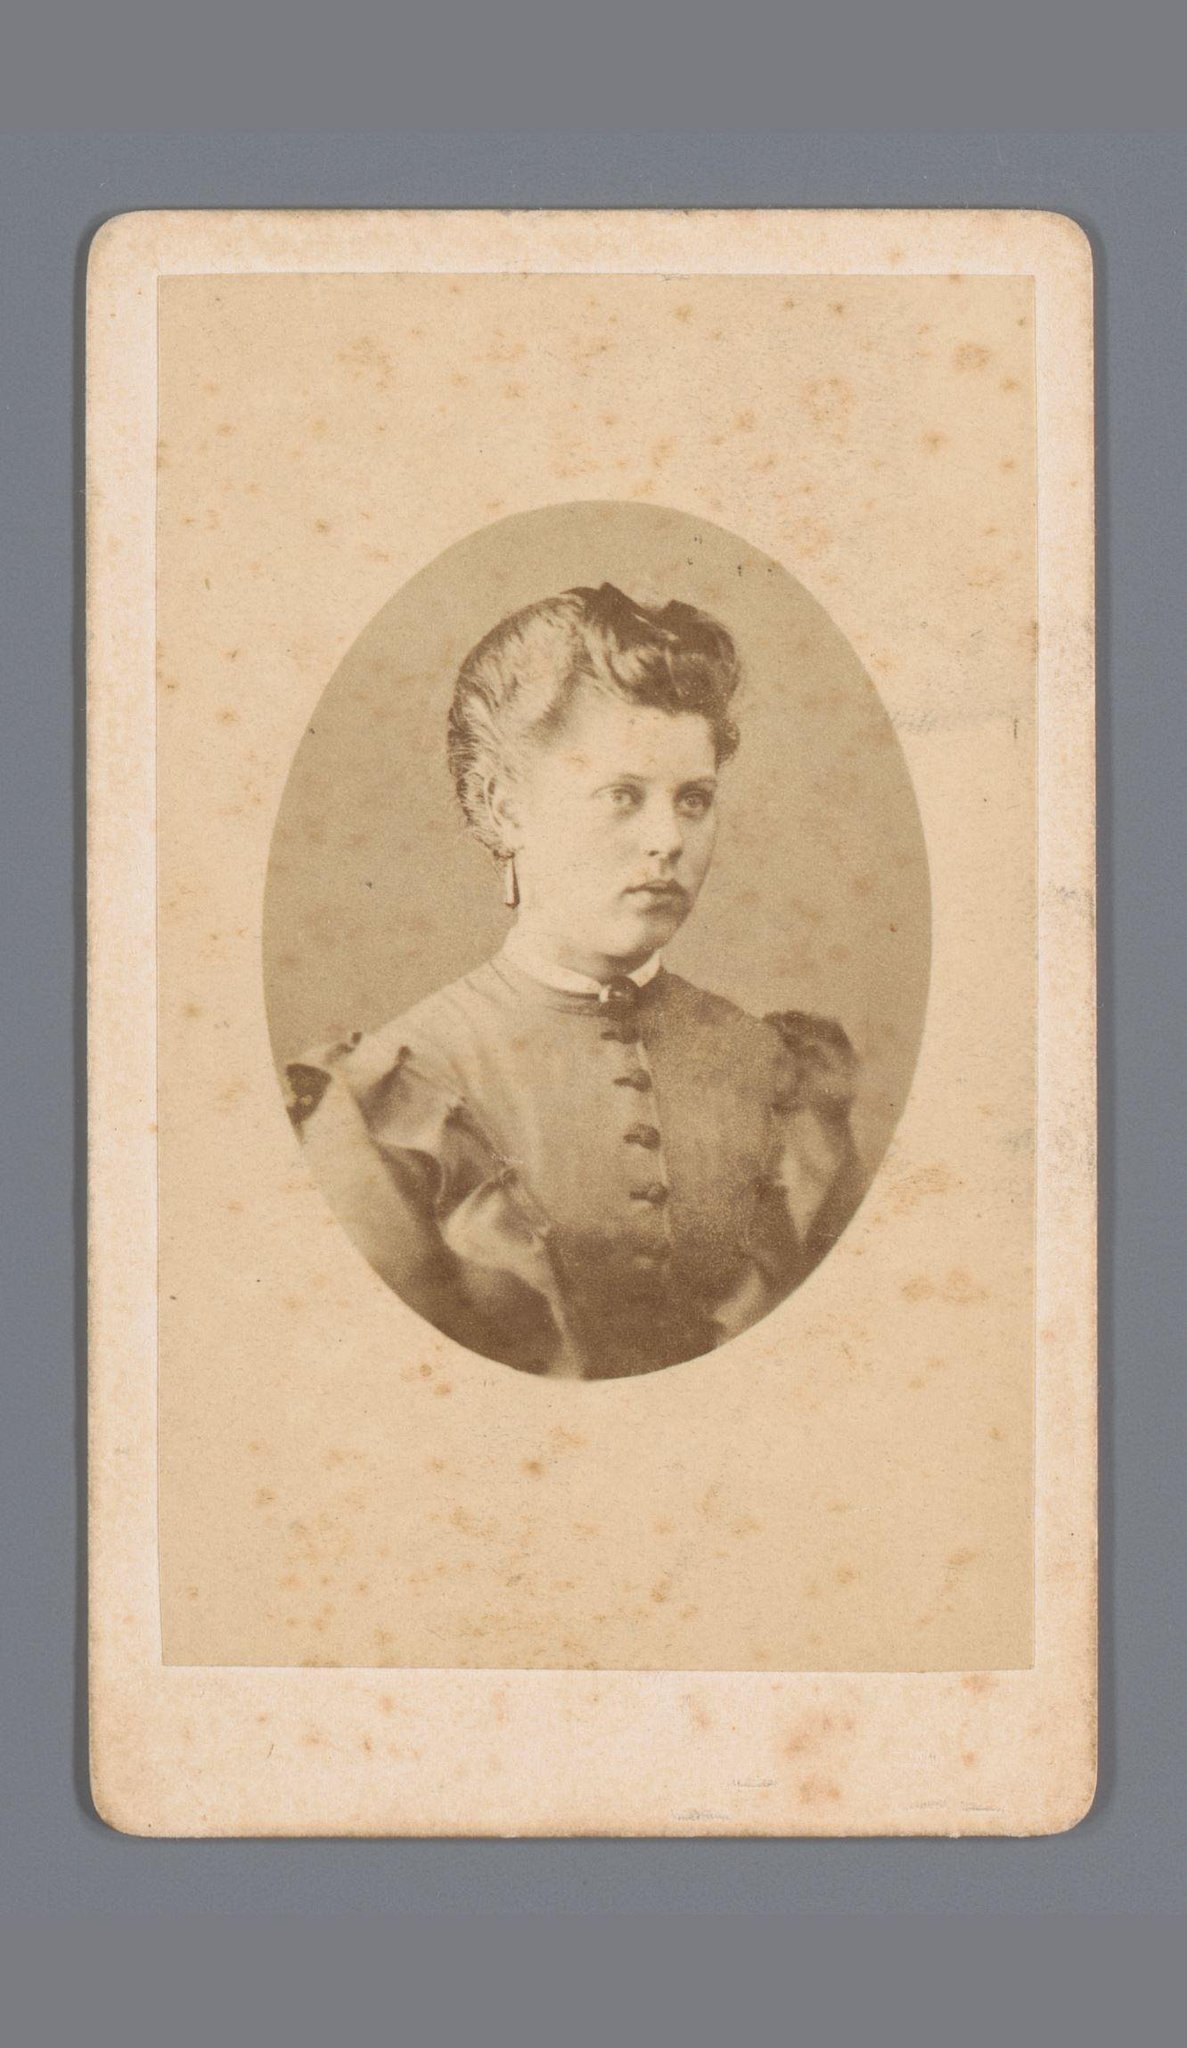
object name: carte de visite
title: Portret van Christine Keyser Temmink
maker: bernardus bruining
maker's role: fotograaf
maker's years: 1834-1900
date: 1860-1877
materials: cardboard, photographic support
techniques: albumen print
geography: leiden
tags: historical persons, leiden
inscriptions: annotation: ‘Christine Keyser-Temmink’, workshop stamp: ‘B. Bruining. Leyden’